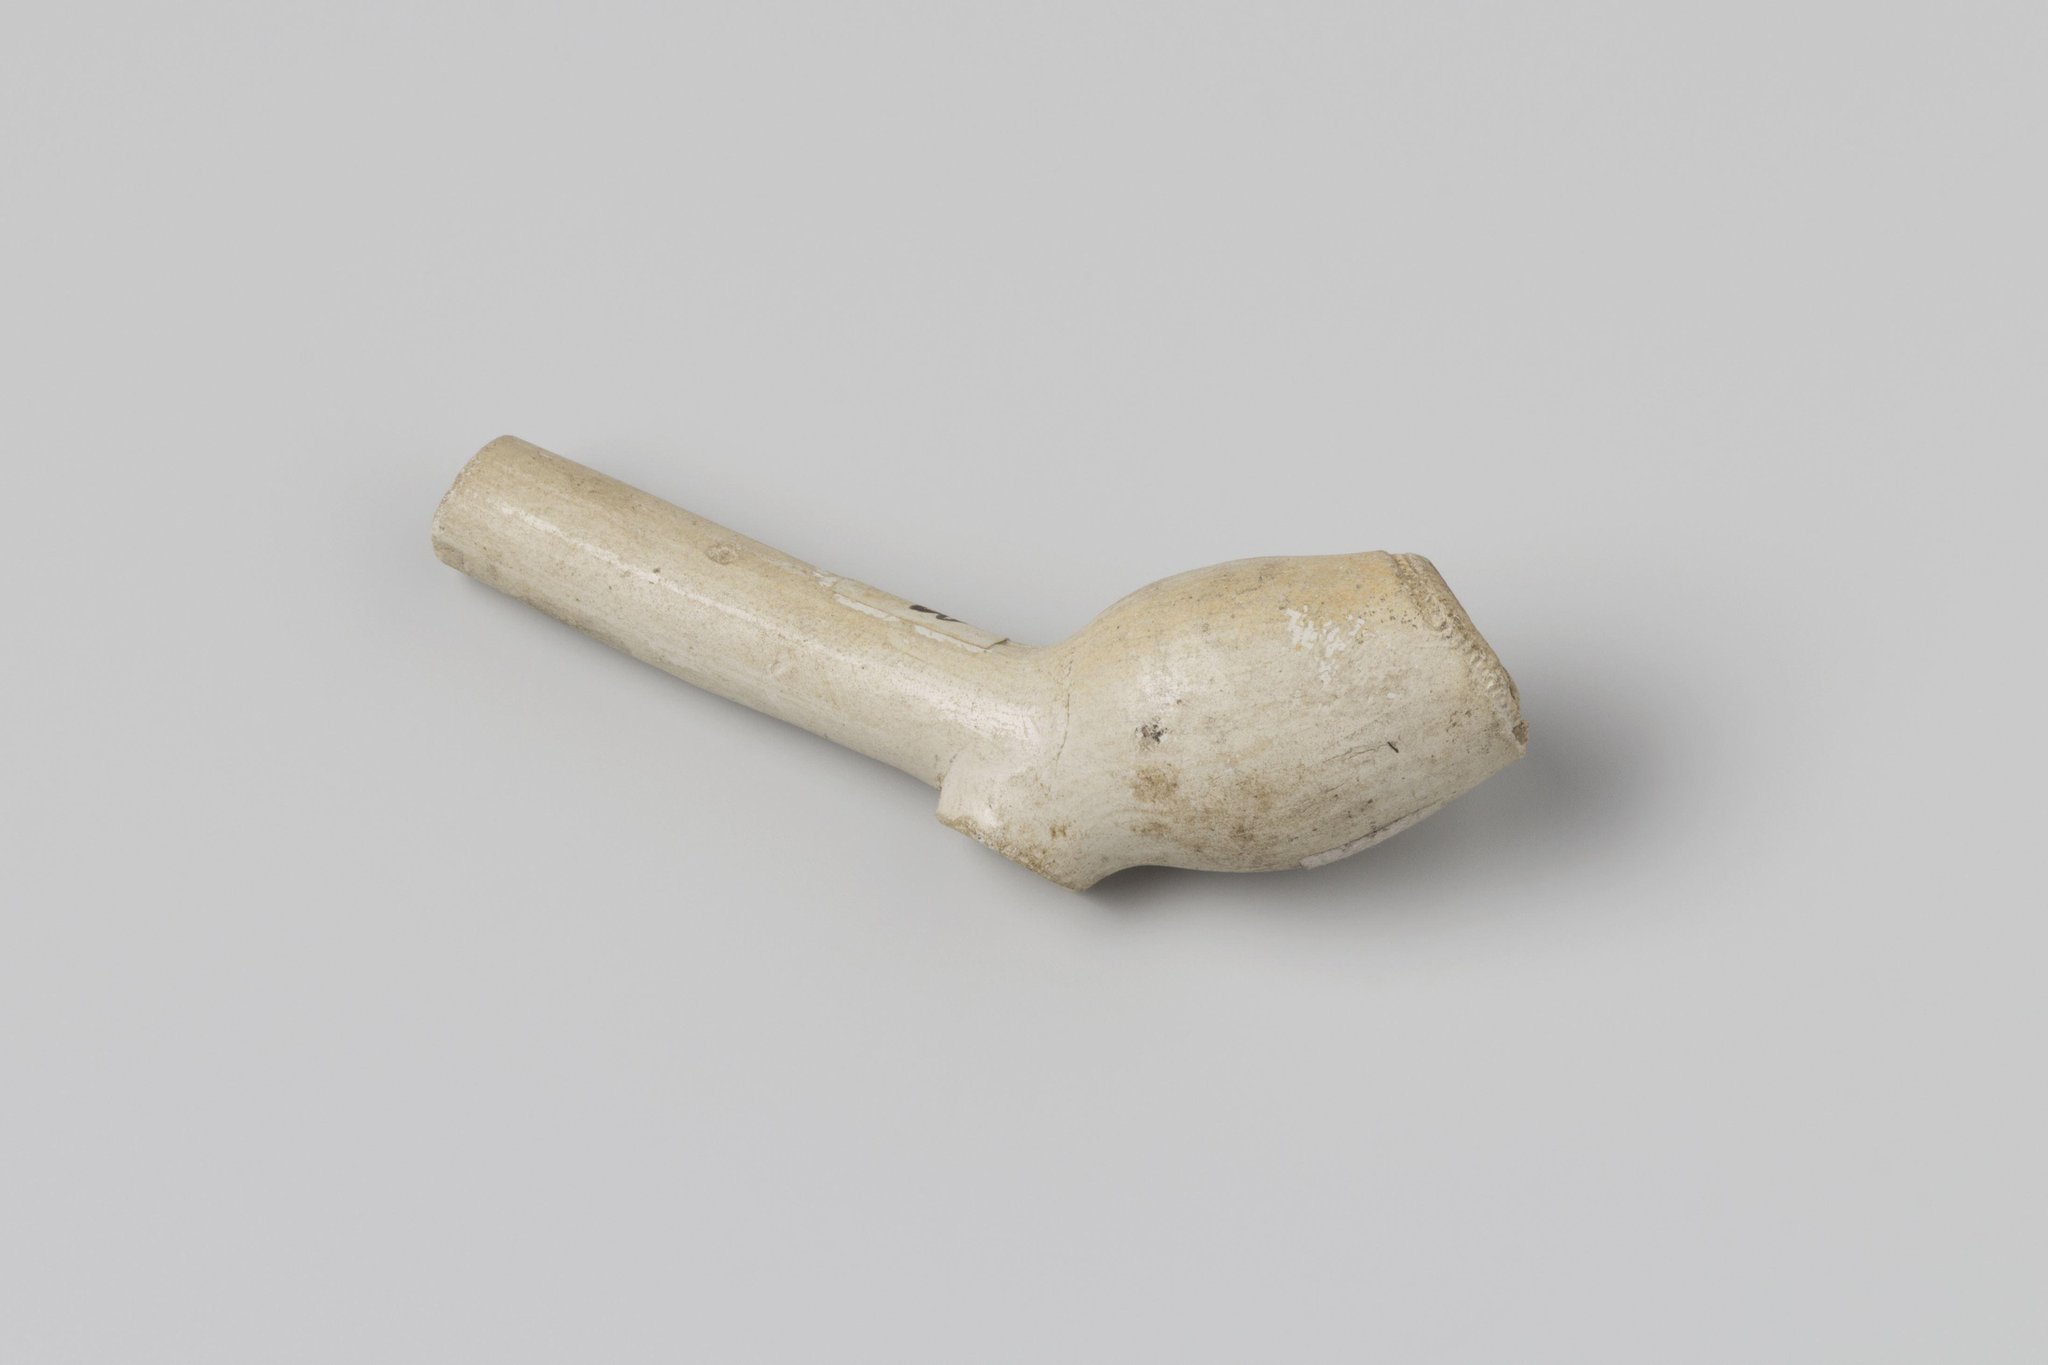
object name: tabakspijp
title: Tabakspijp.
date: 1400-1950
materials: earthenware, clay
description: Tabakspijp. Stempel: Gekroonde roos en I.D.